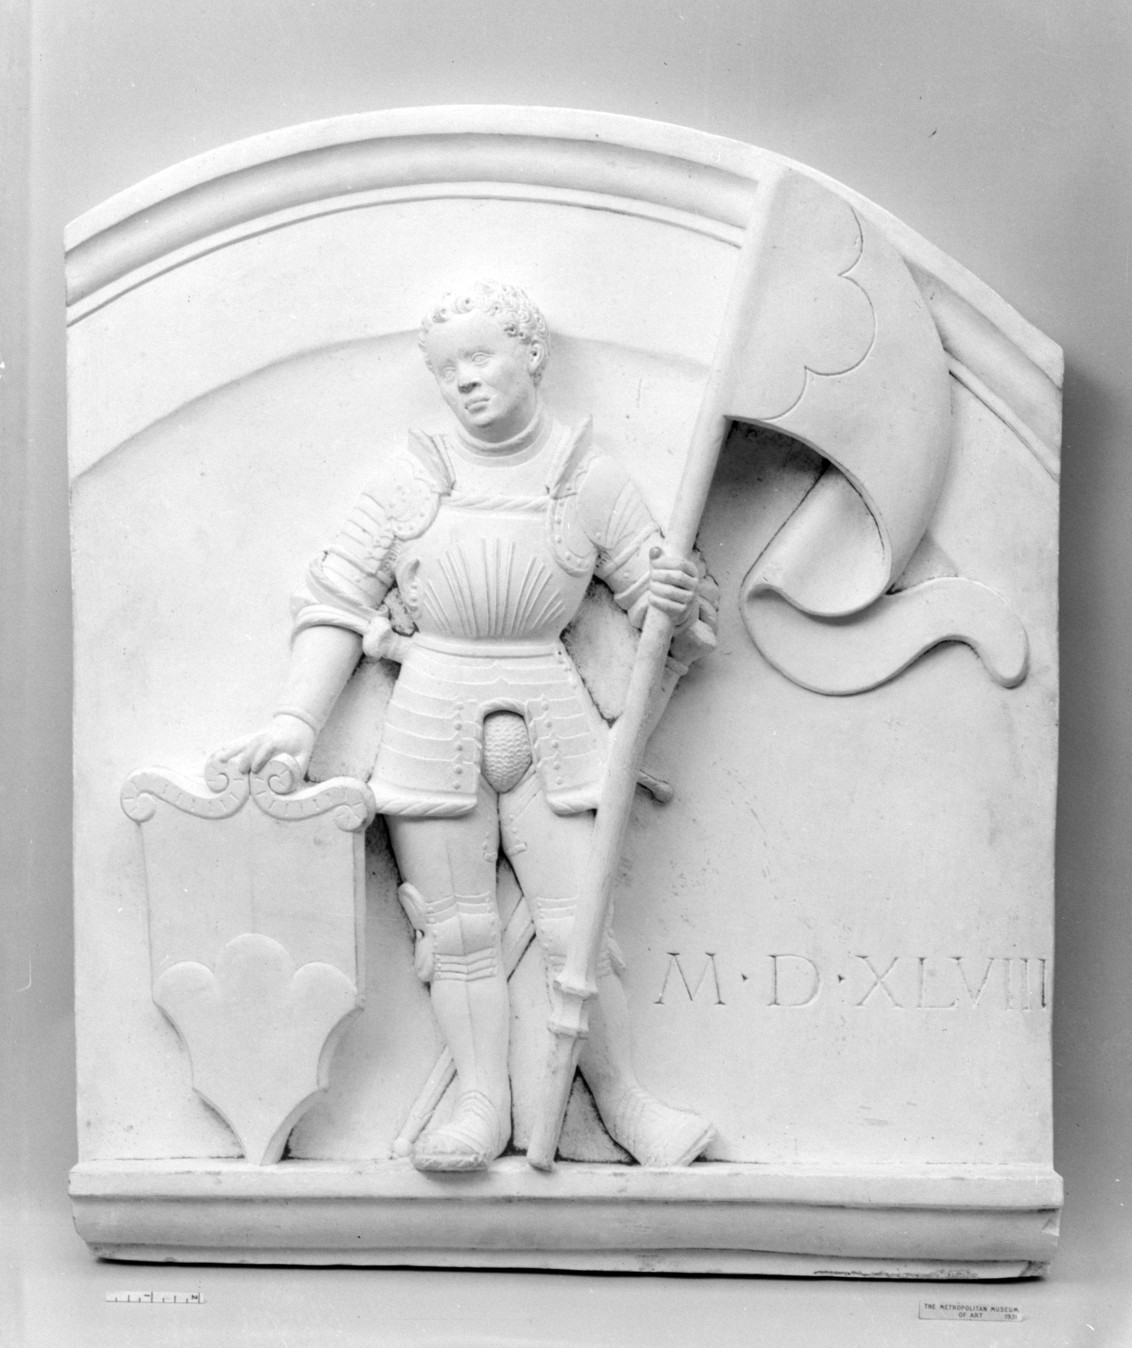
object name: relief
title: St. Willibald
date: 1501-1600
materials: stone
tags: shields,saints,flags